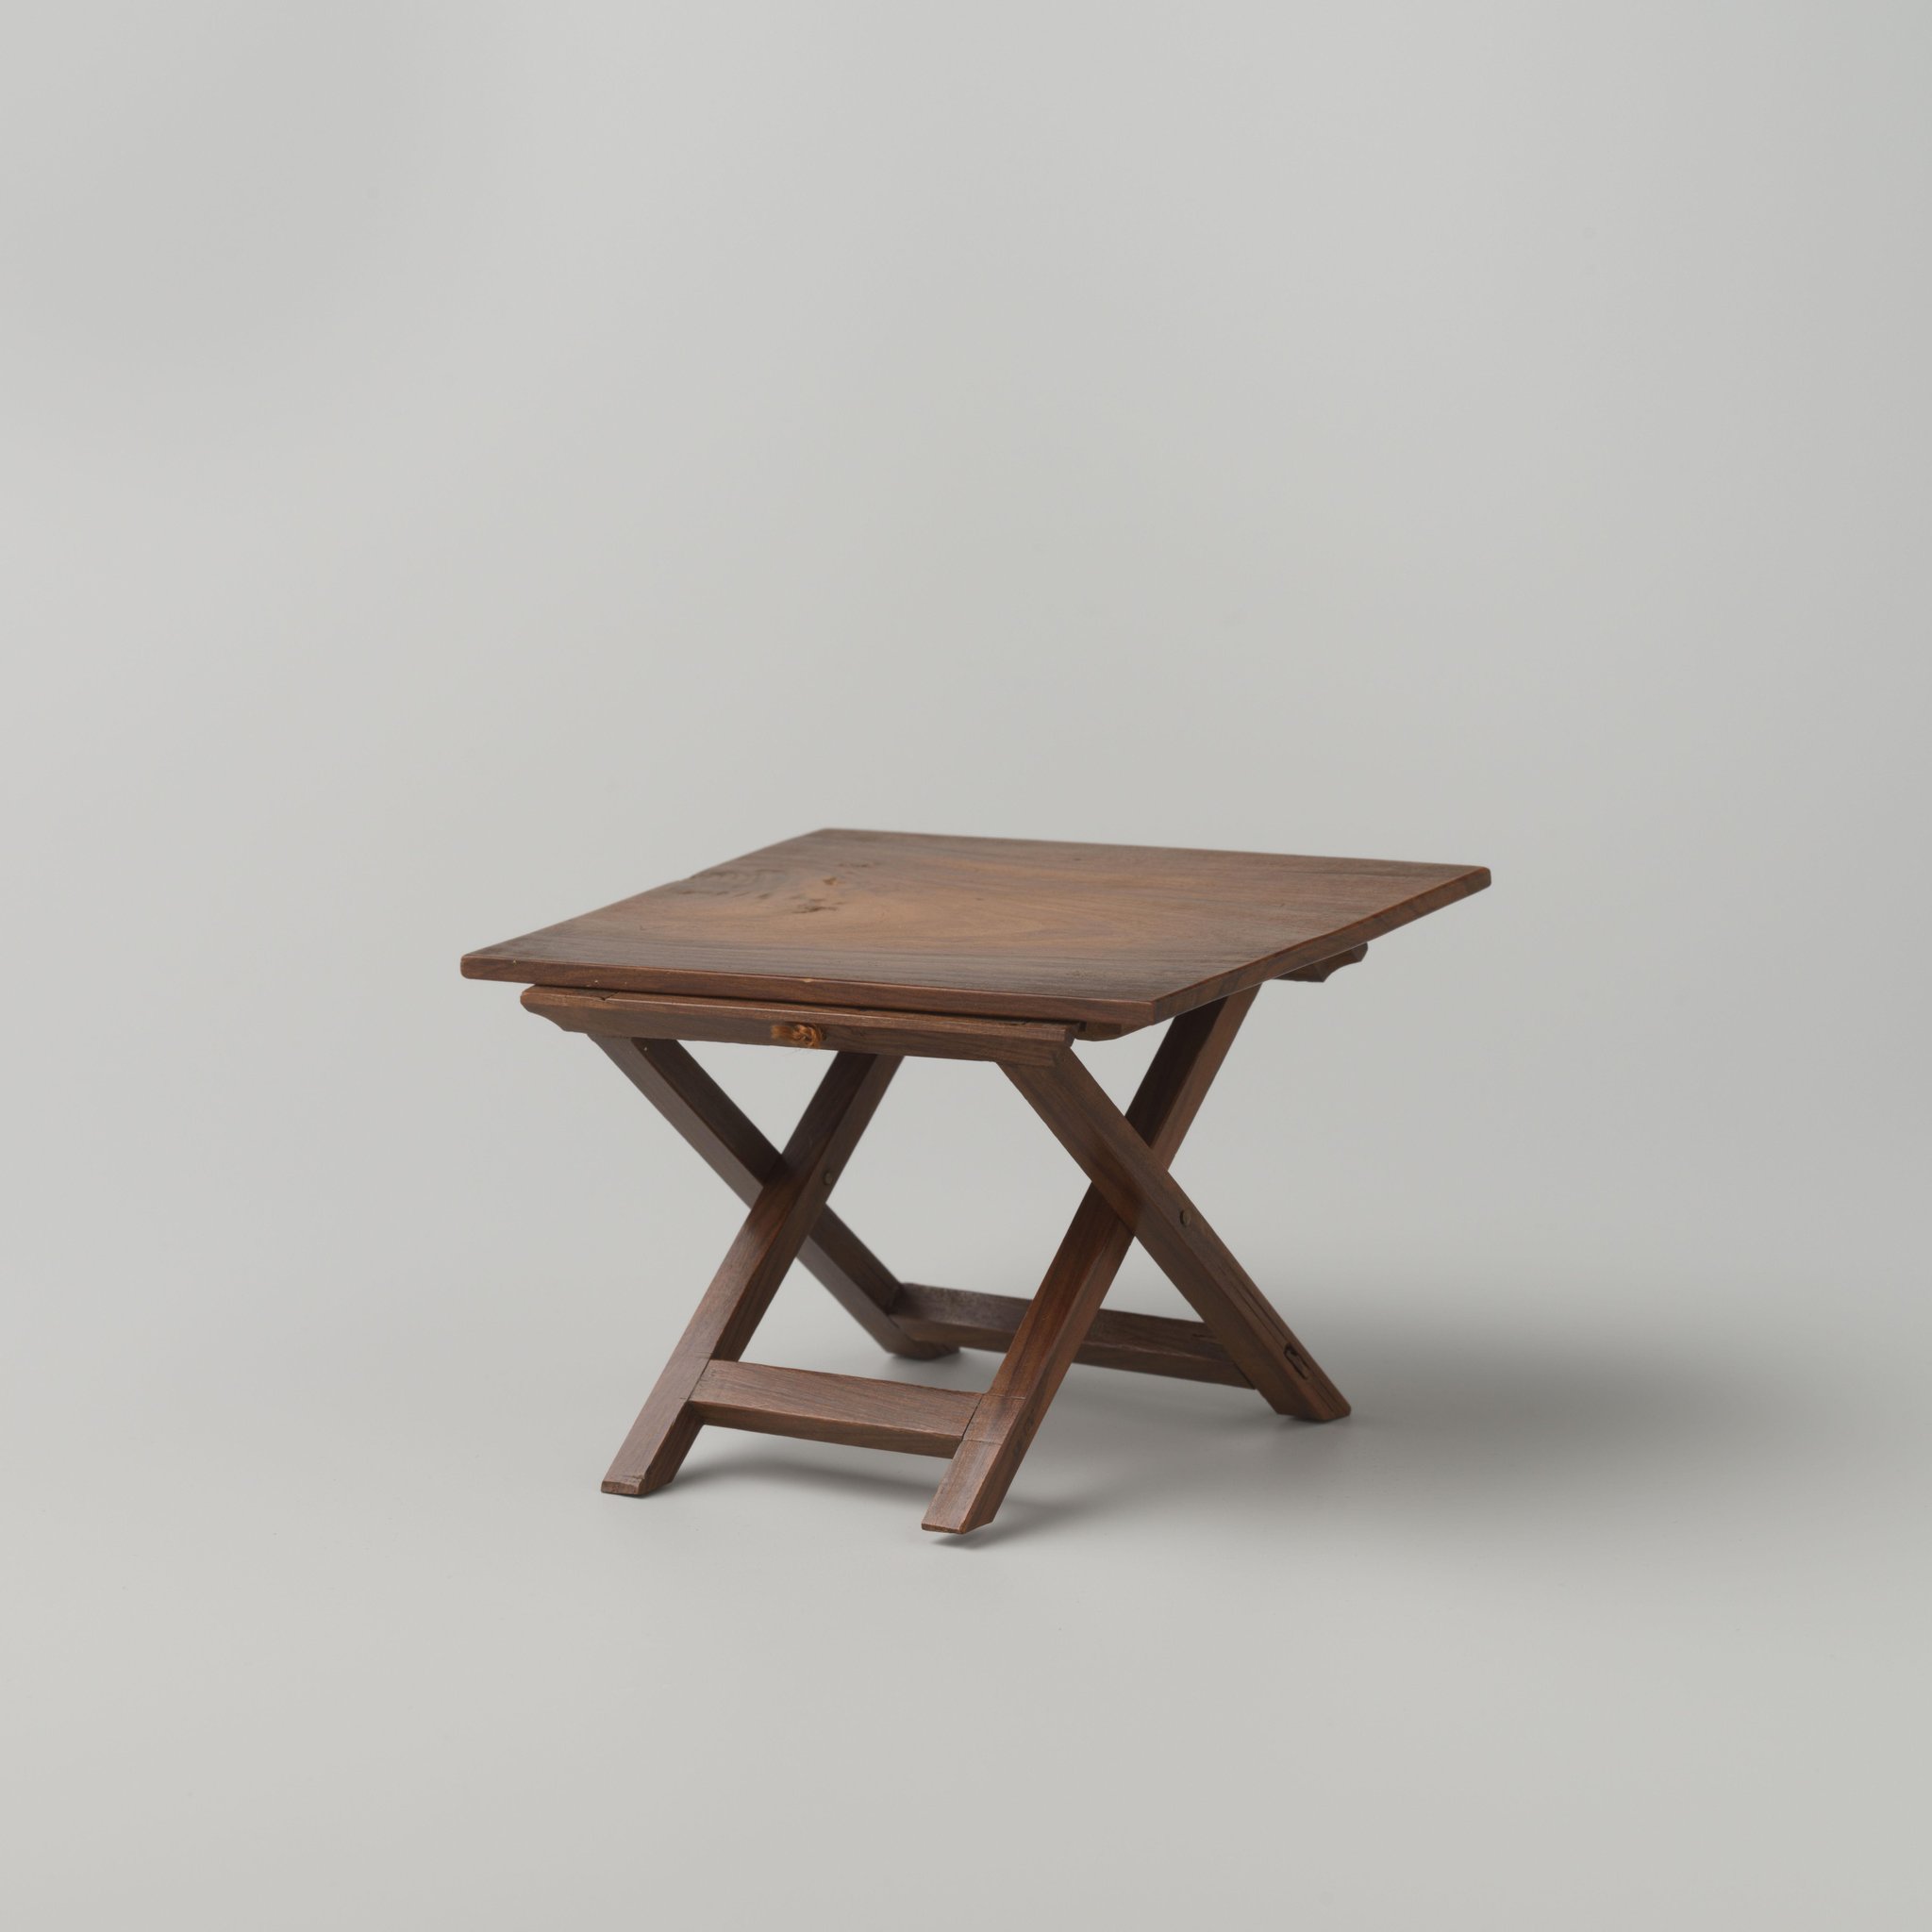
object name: miniature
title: Tafel, bestaande uit een los, rechthoekig blad en een x-vormig inklapbaar onderstel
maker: Anonymous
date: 1690-1710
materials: wood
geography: amsterdam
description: Tafel vervaardigd van olijfhout, bestaande uit een los, rechthoekig blad en een x-vormig inklapbaar onderstel. Aan de onderzijde van het blad zijn twee regels bevestigd, waartussen de bovenregels van de schraag passen; een bruin zijden koordje voorkomt eveneens het doorzakken van het onderstel.